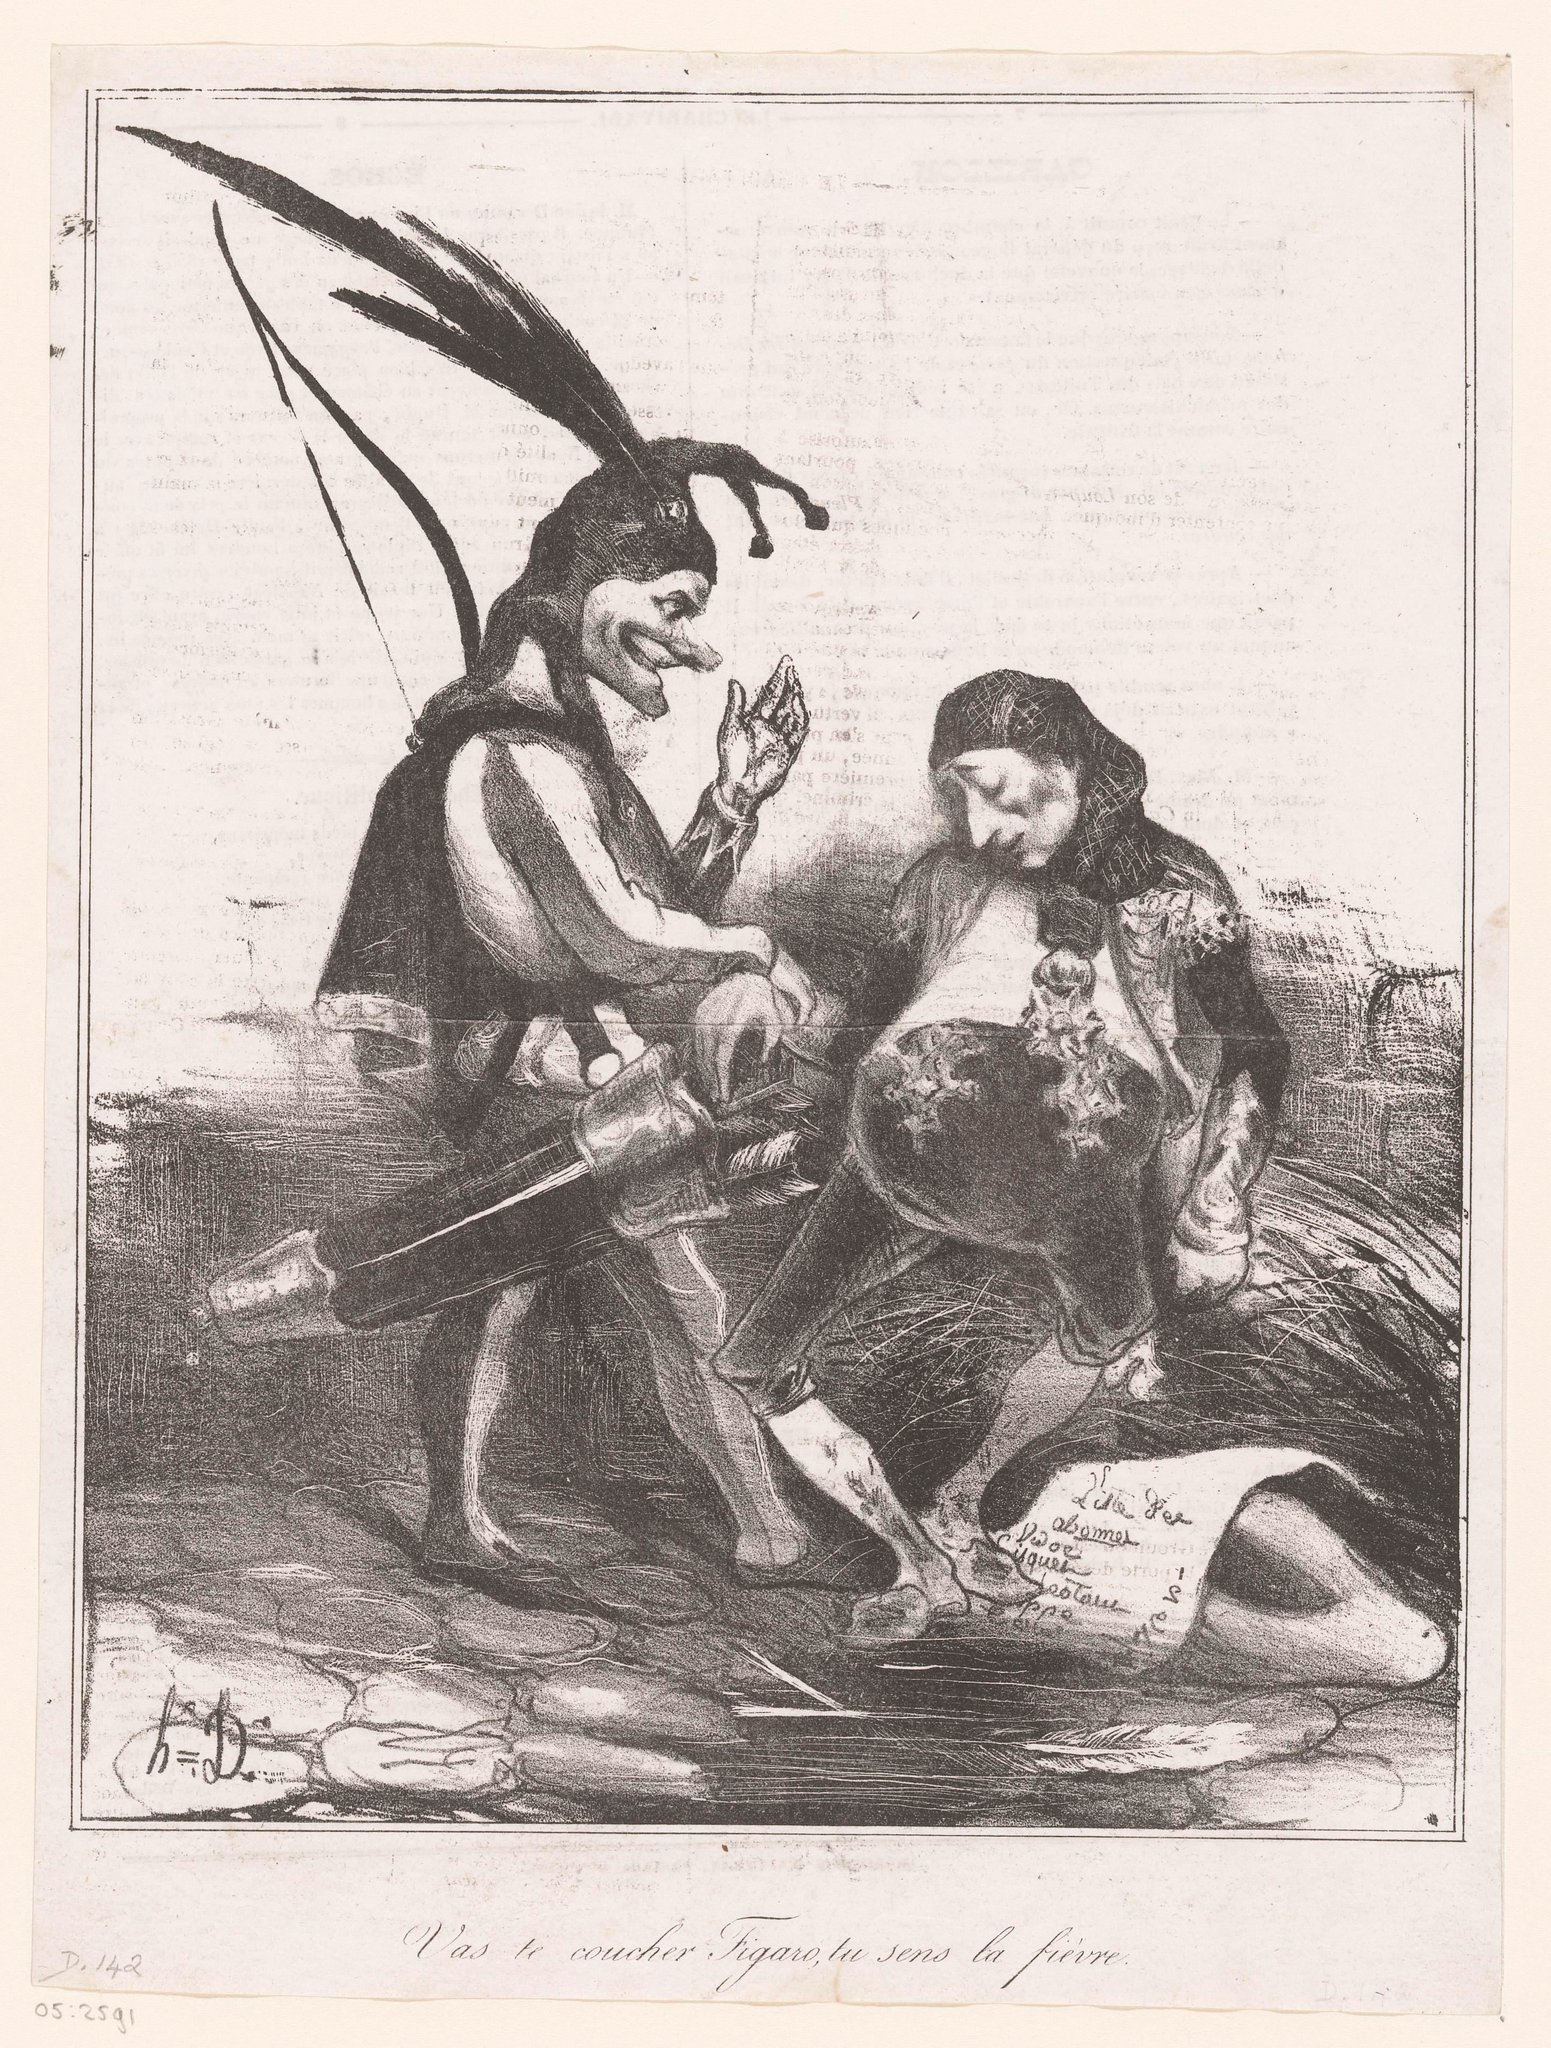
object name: print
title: Karikatuur van Le Figaro en Le Charivari als narren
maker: honoré daumier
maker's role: draughtsman, painter, print maker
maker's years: 1808-1879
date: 1833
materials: paper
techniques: lithograph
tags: court jester, court fool, caricatures (human types), newspaper, news-sheet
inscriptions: collector's mark: Lugt 2228a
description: Prent gepubliceerd in: Le Charivari, 26 februari 1833. Le Charivari was een humoristische krant met karikaturen en (politieke) cartoons.